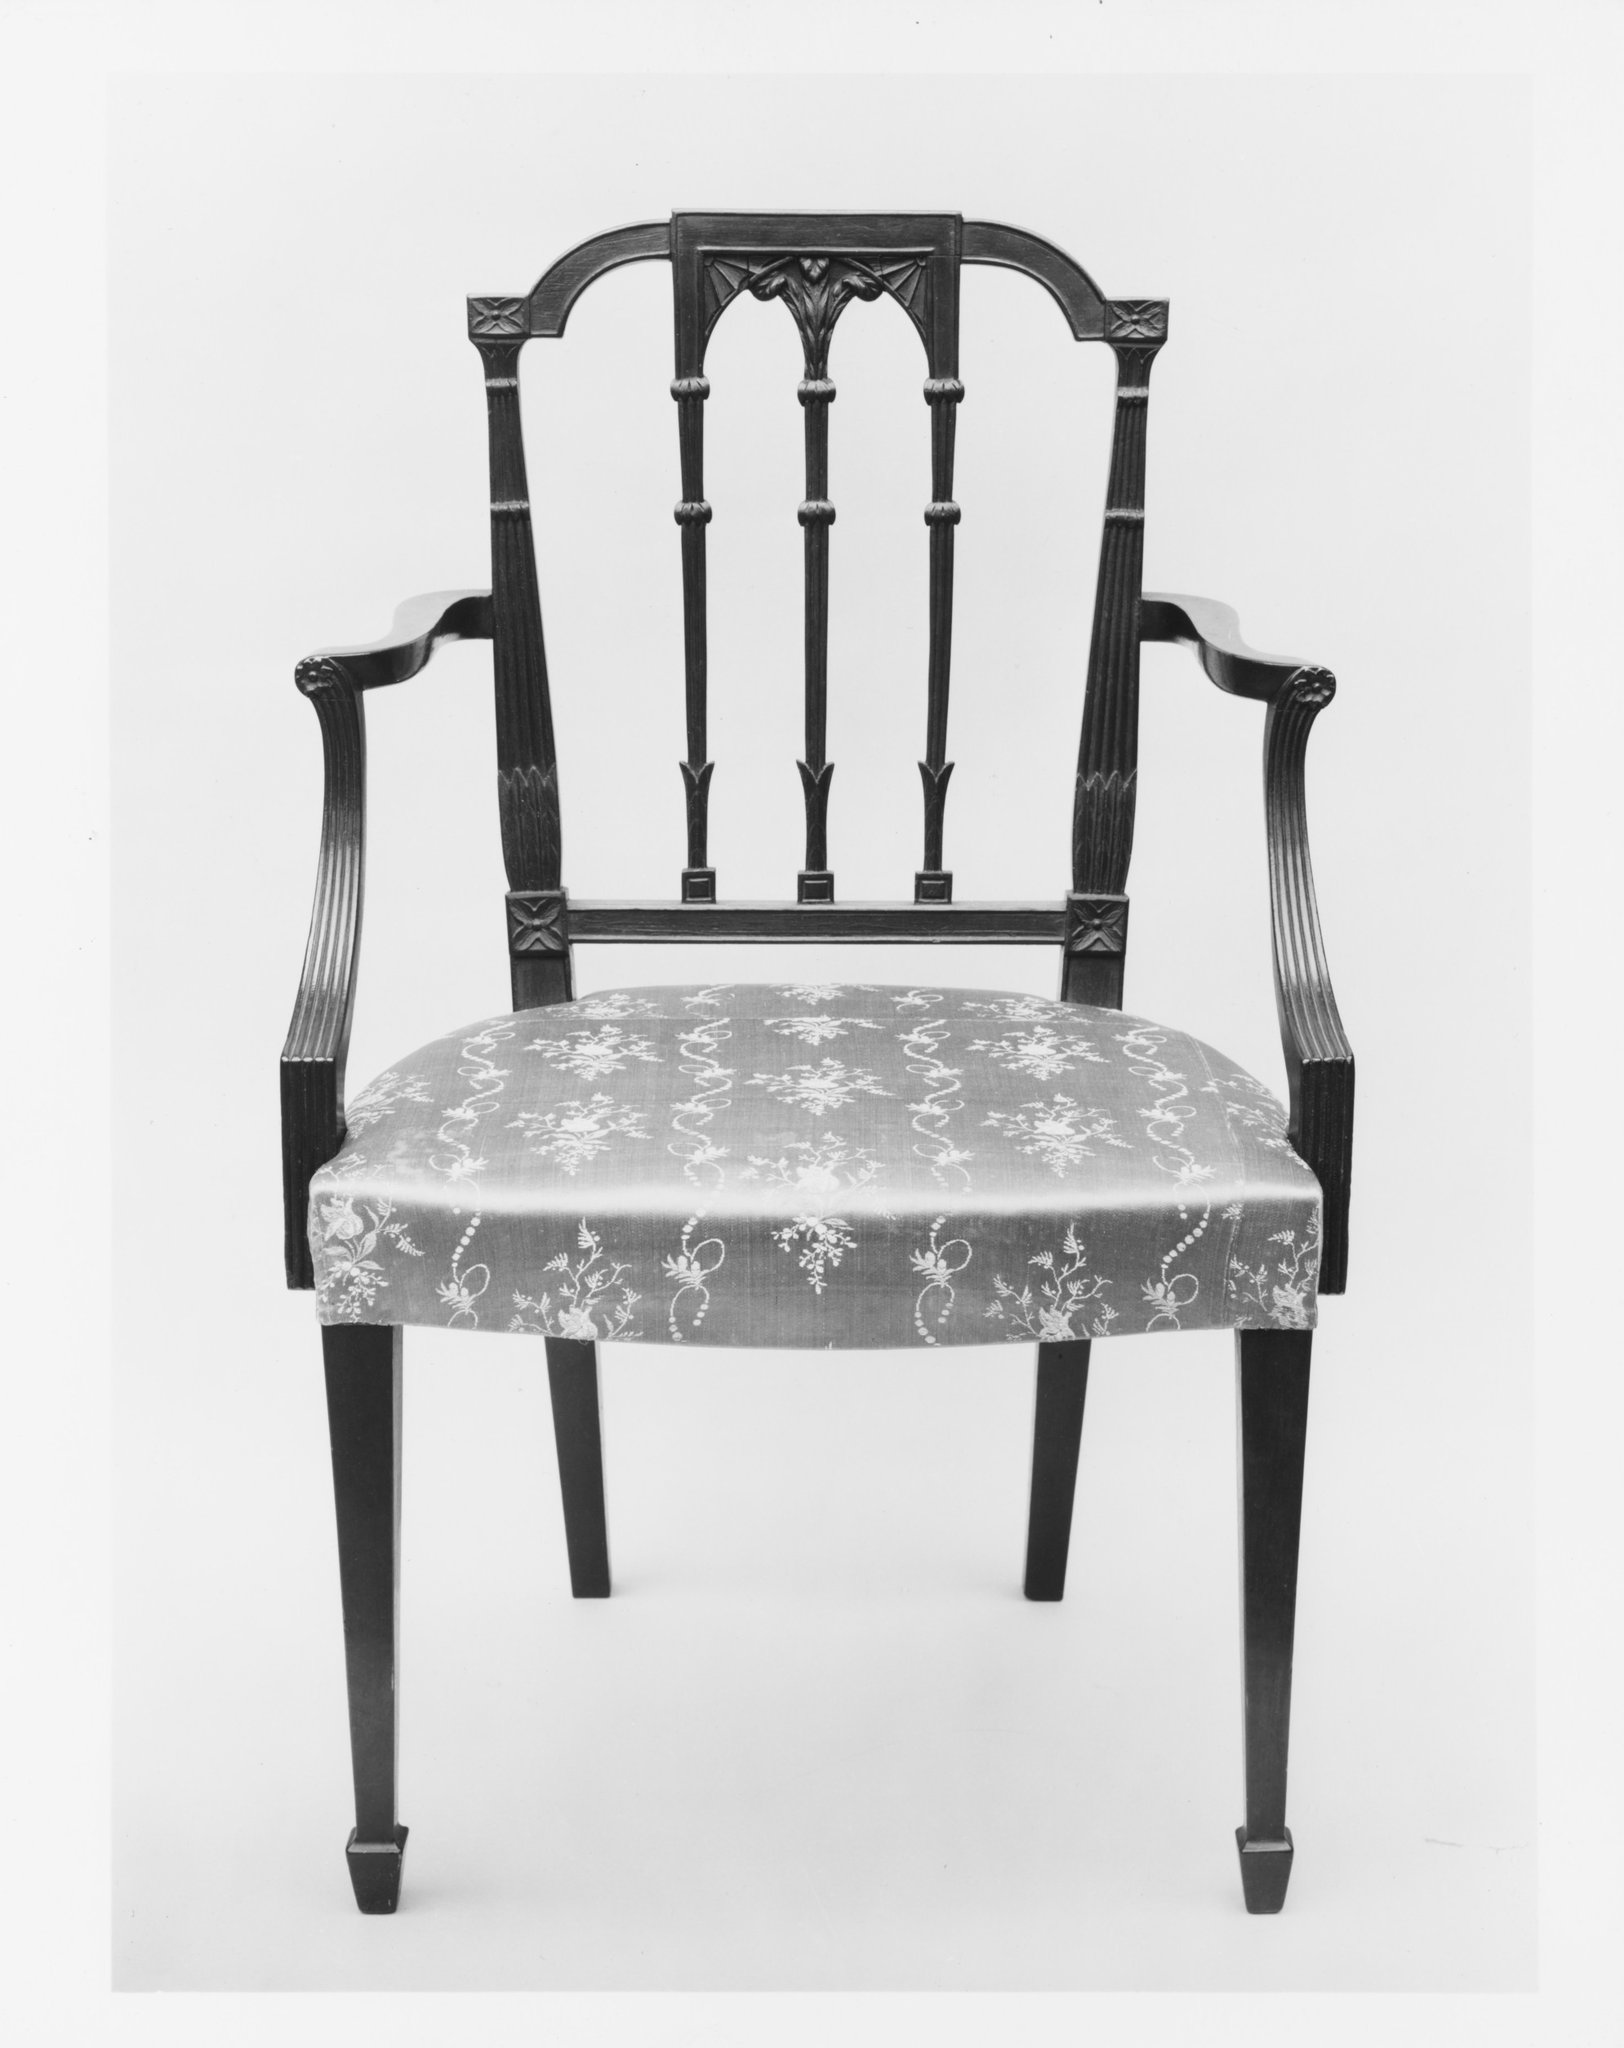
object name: armchair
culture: american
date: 1795-1810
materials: wood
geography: united states